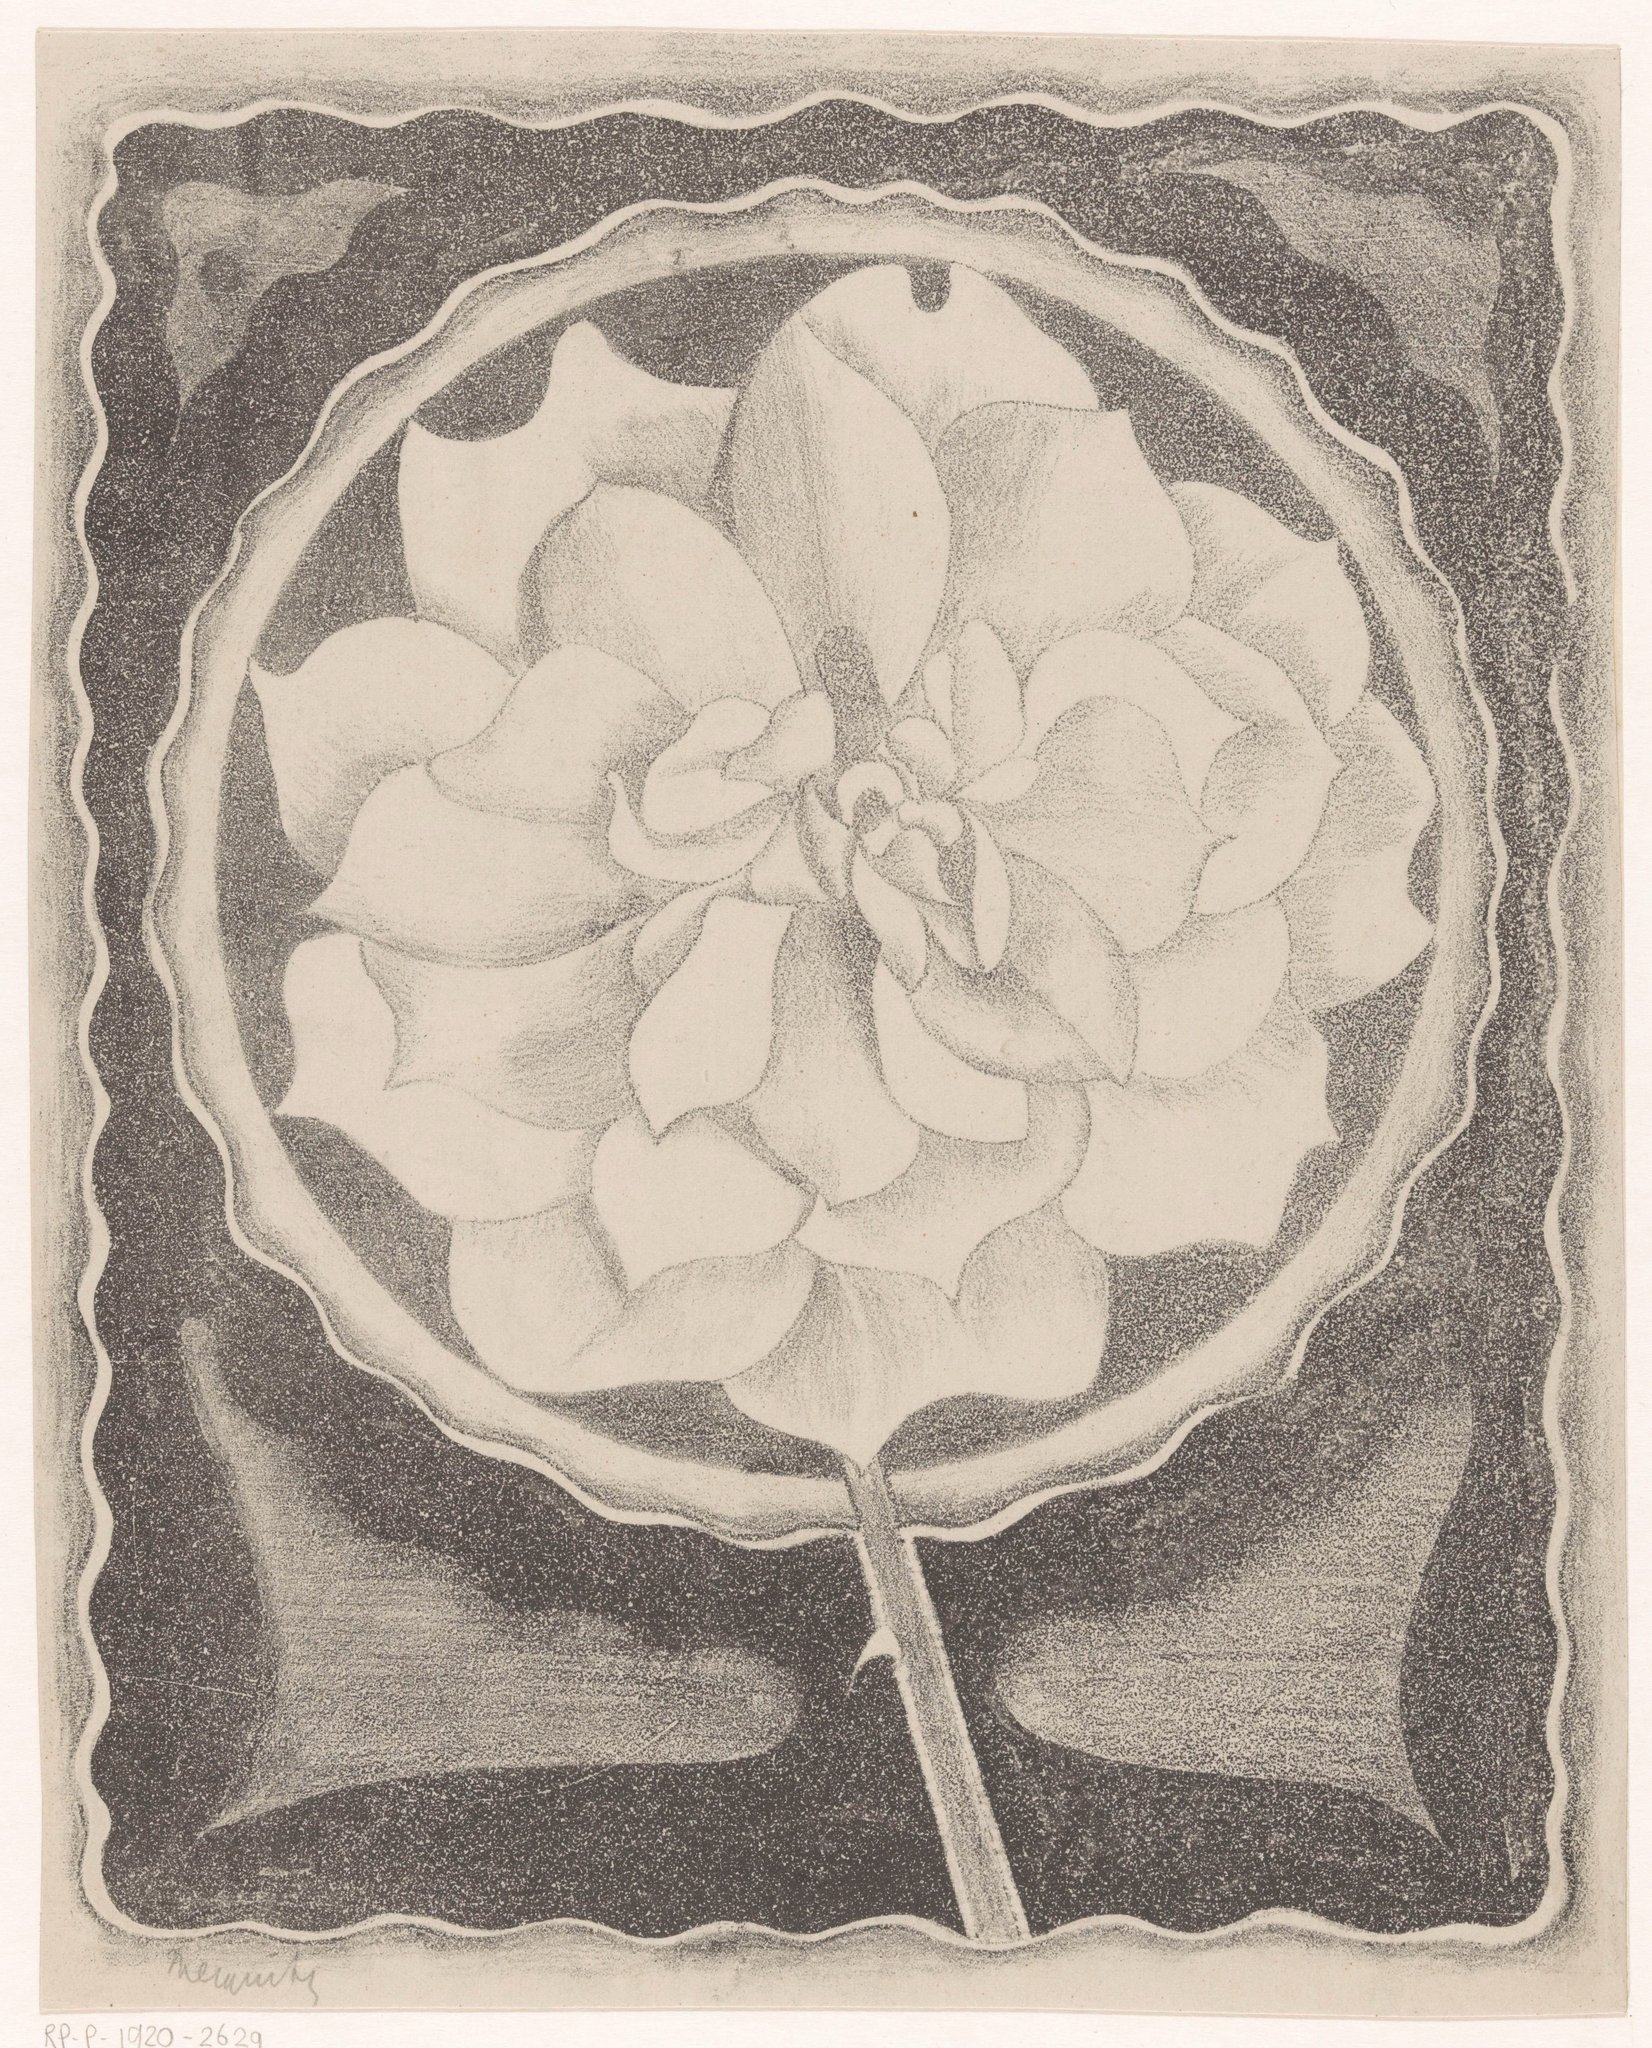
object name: print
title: Roos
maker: samuel jessurun de mesquita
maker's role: draughtsman, print maker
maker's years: 1868-1944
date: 1920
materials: paper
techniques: lithograph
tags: flowers: rose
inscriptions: collector's mark: Lugt 2228